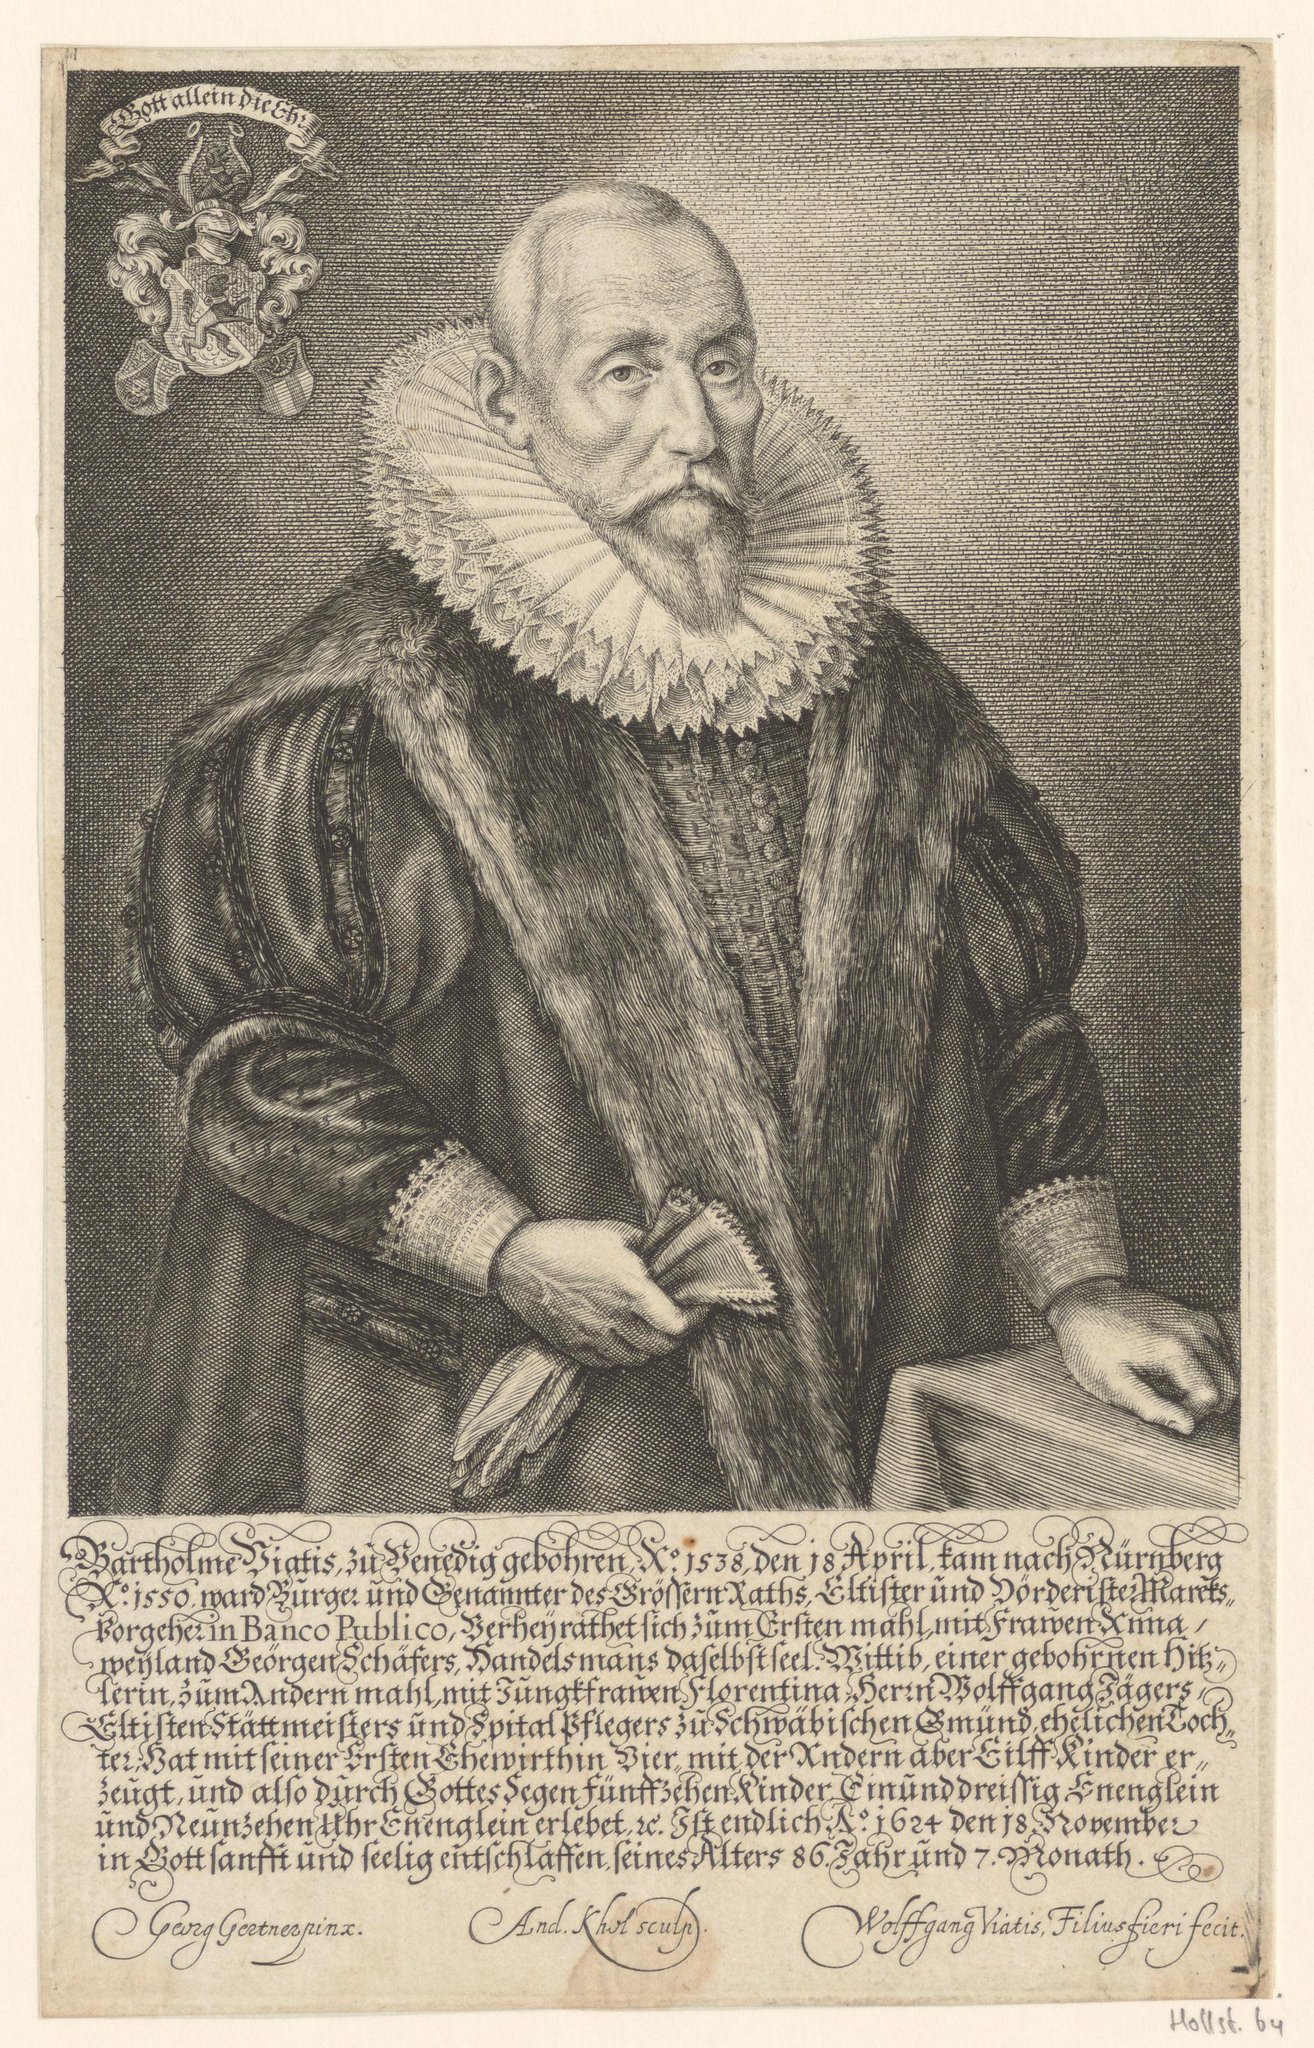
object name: print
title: Portret van Bartholomaeus Viatis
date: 1634-1657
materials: paper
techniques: engraving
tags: venice, historical persons, counsellor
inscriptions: collector's mark: Lugt 2228